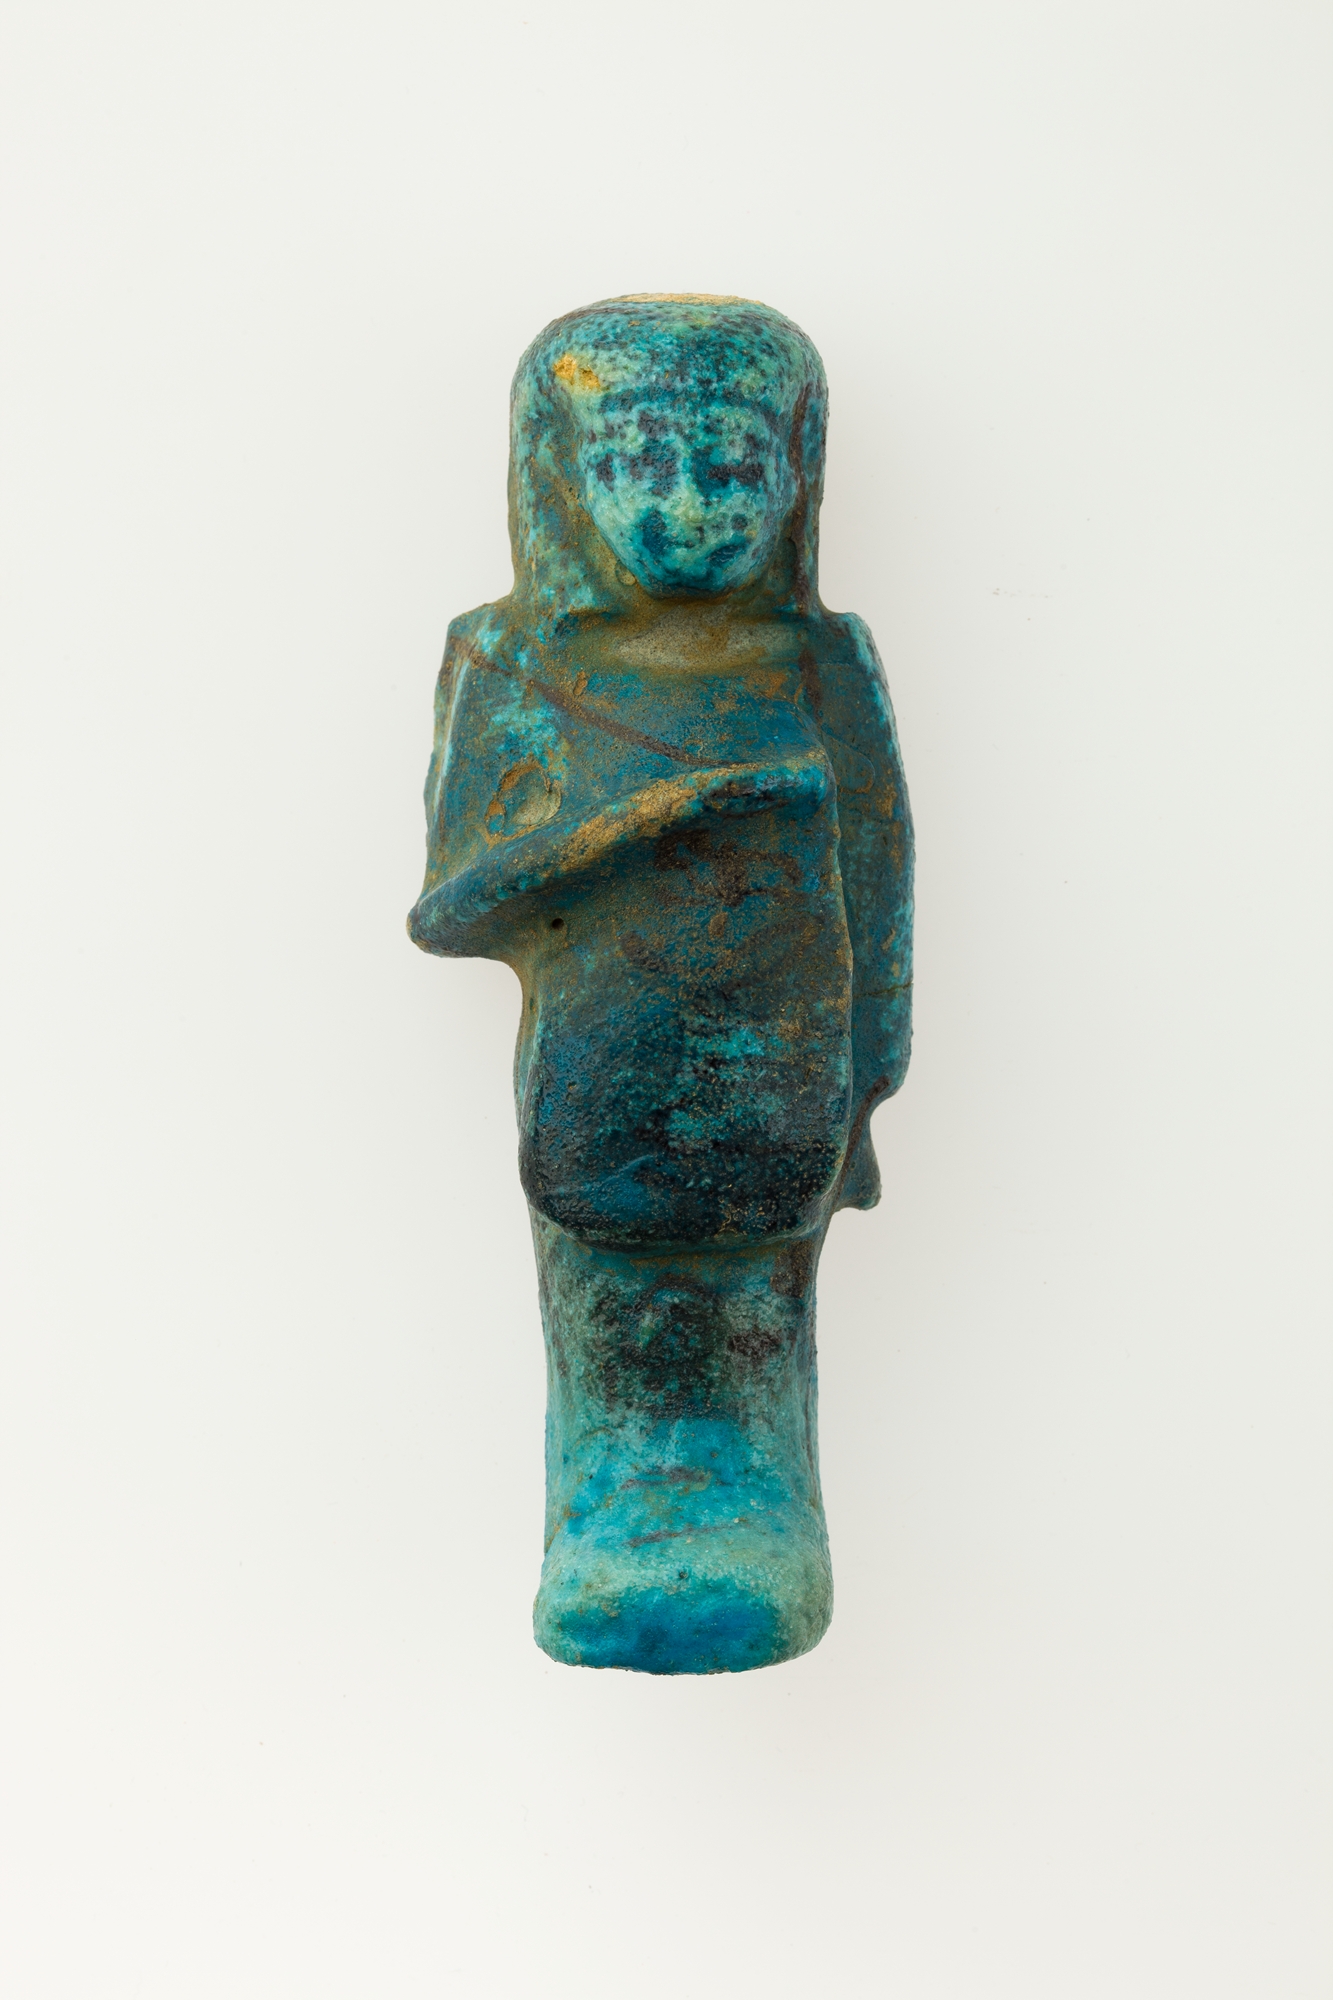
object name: shabti, henettawy c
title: Overseer Shabti of Henettawy (C), Daughter of Isetemkheb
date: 990-970 BCE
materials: faience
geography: egypt